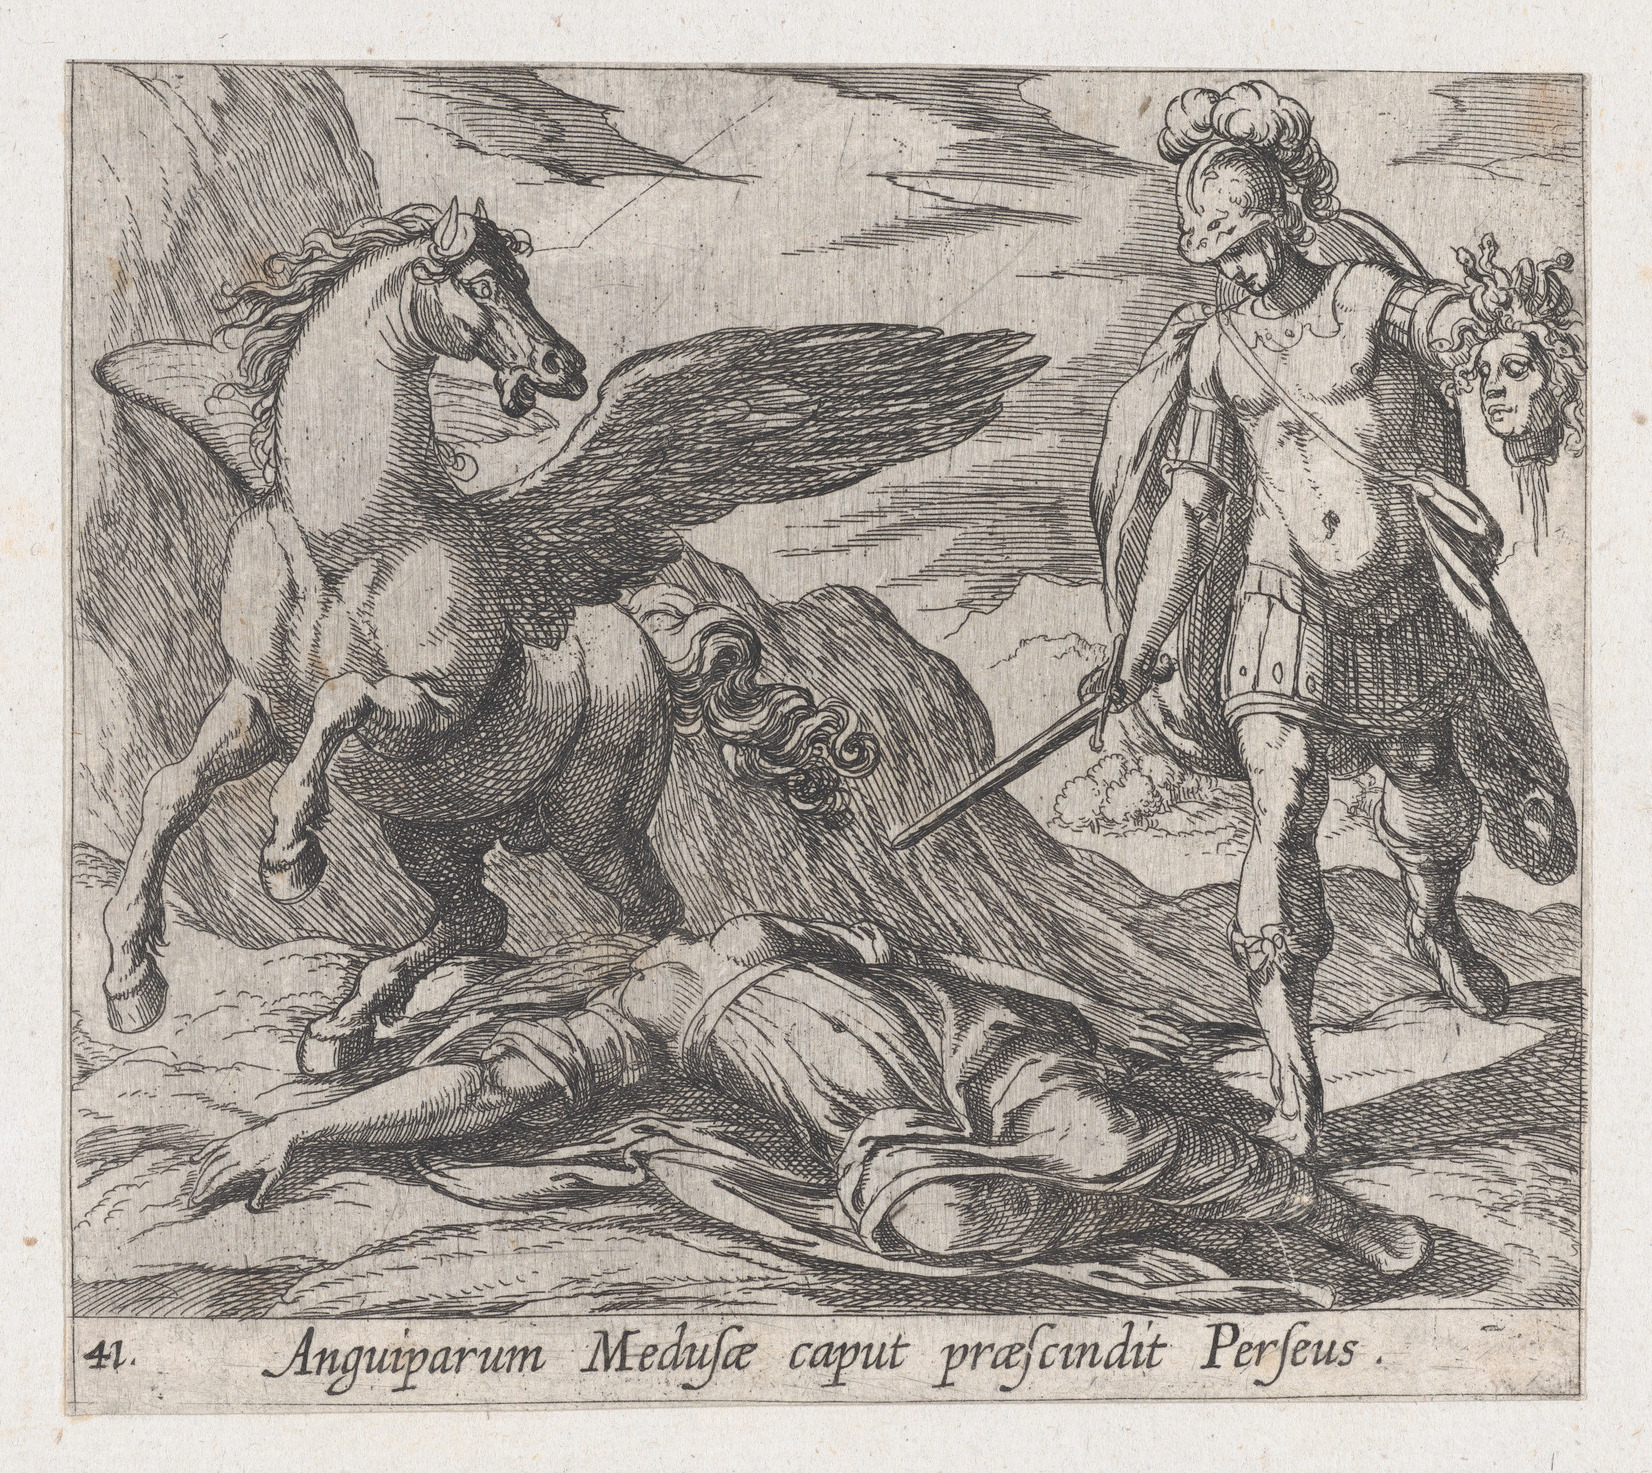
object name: print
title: Plate 41: Perseus Killing Medusa (Anguiparum Meduse caput praescundit Perseus), from Ovid's 'Metamorphoses'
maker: antonio tempesta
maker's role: artist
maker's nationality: italian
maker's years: 1555-1630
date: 1606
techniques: etching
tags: swords,medusa,perseus,pegasus